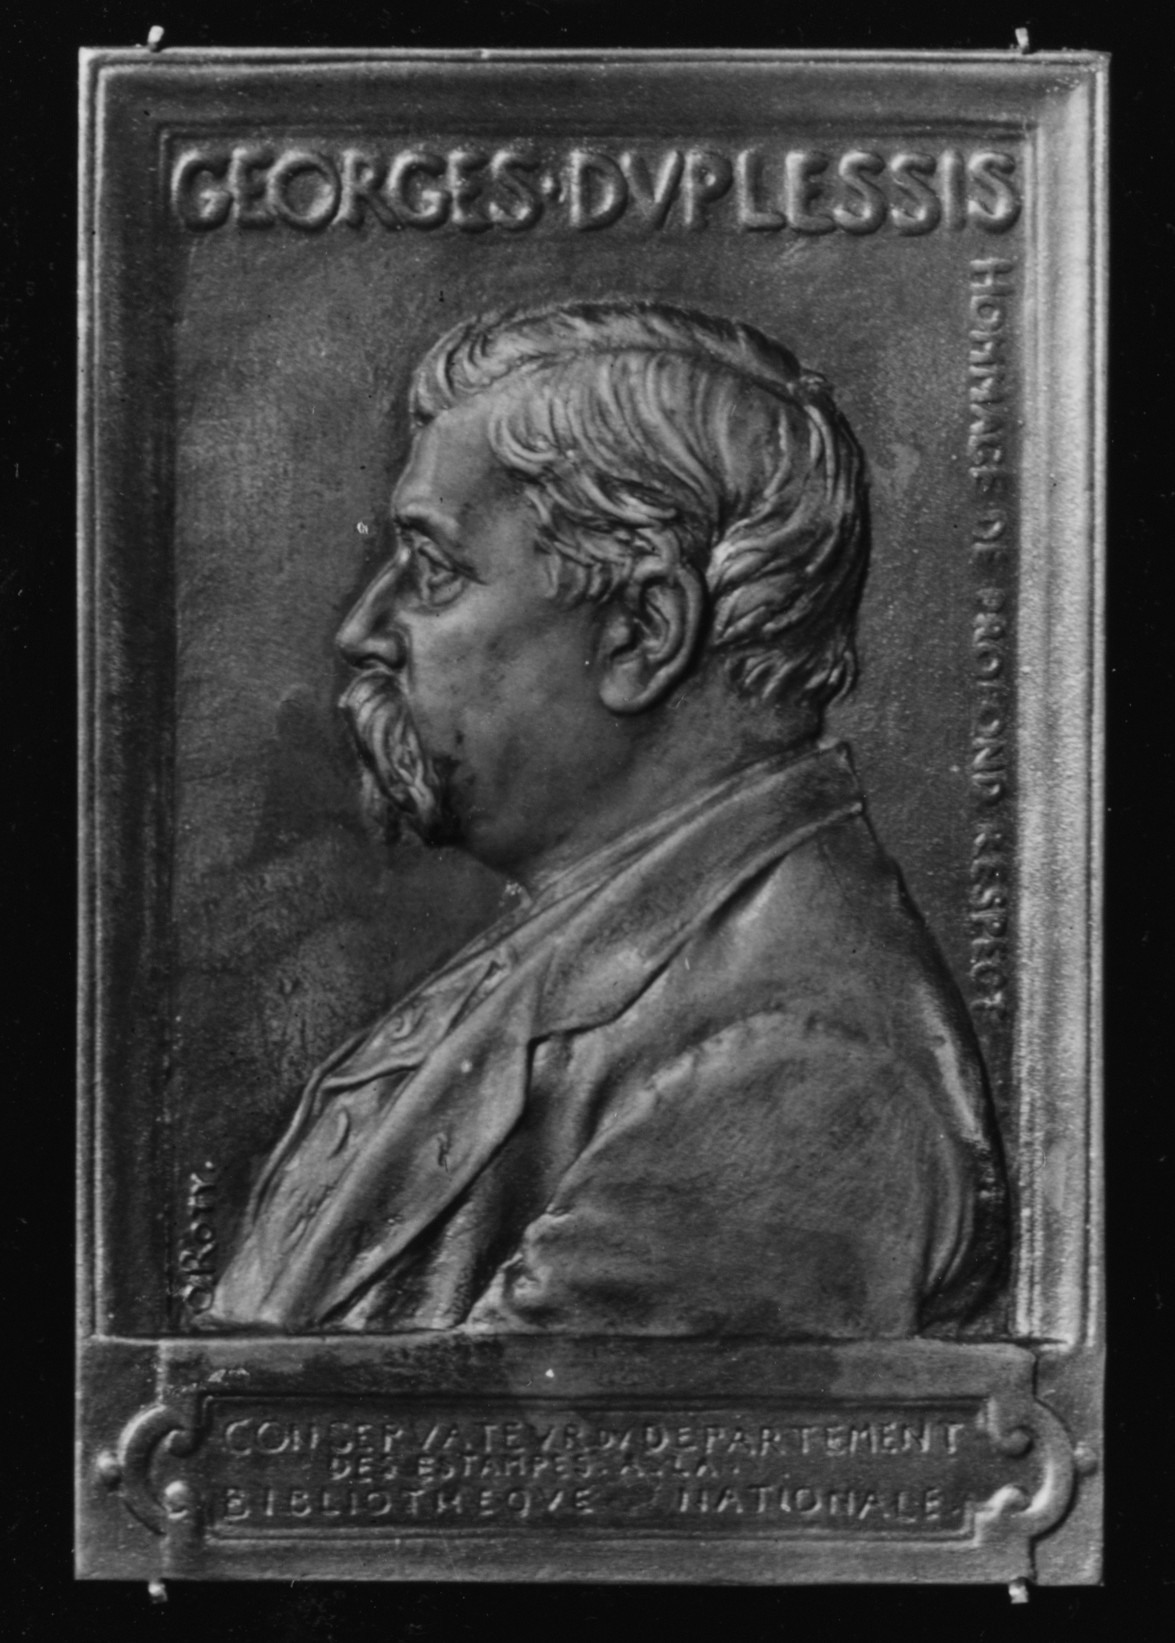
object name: plaque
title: In Honor of George Duplessis, Curator of Prints, Bibliothéque National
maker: louis-oscar roty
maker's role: artist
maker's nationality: french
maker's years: 1846-1911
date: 1886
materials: bronze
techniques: casting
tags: men,profiles